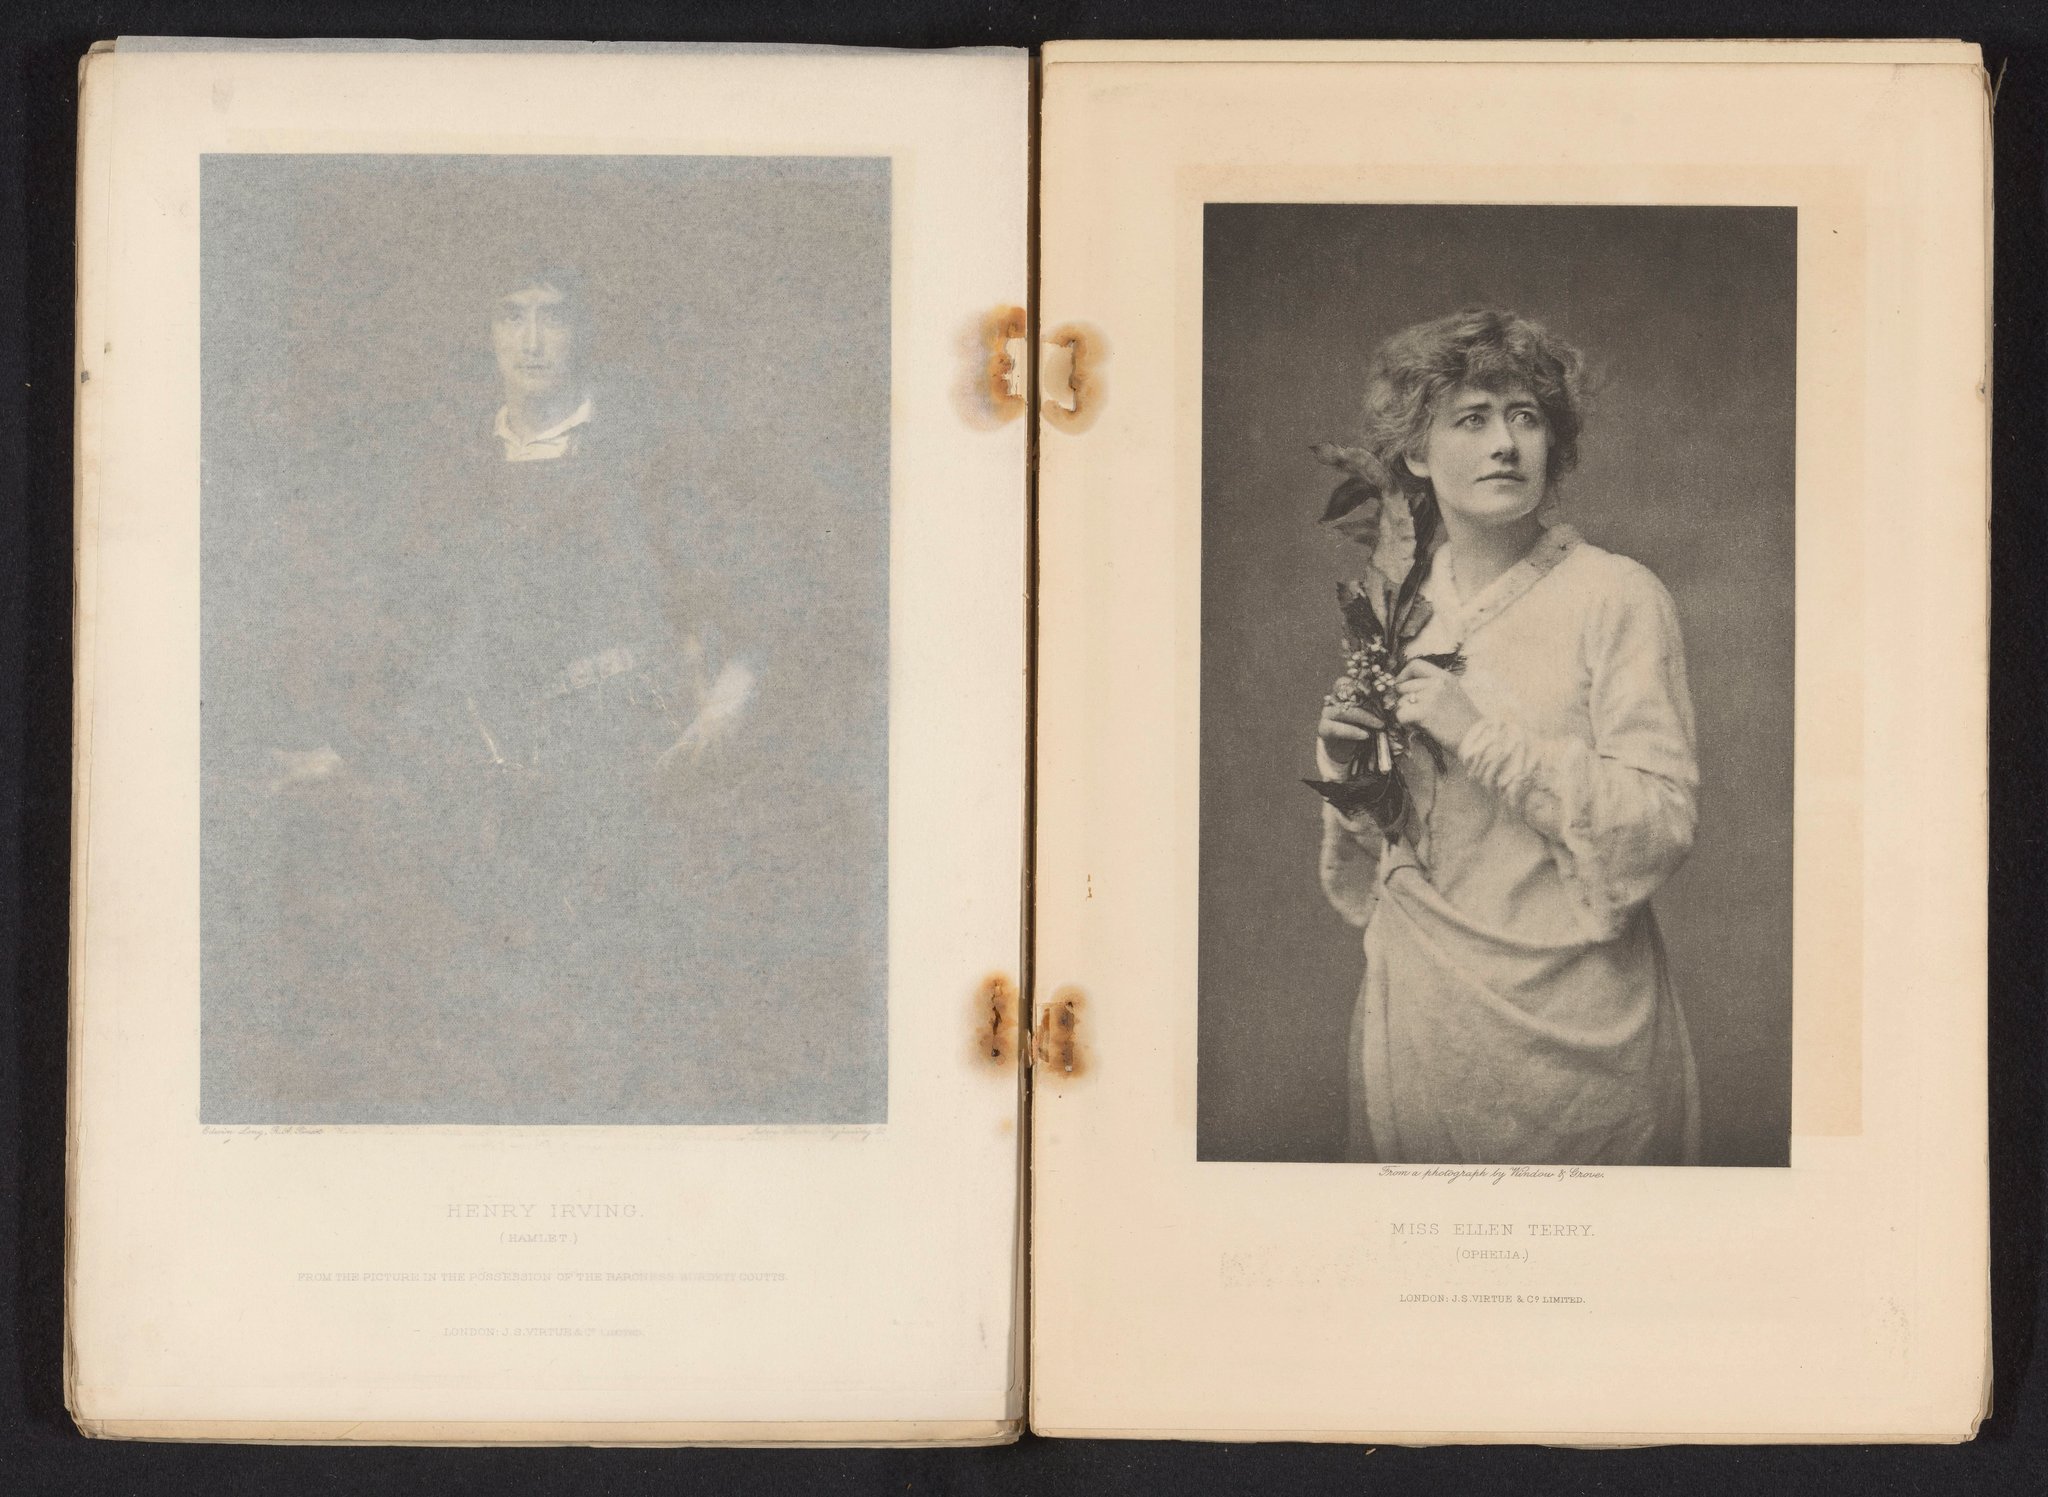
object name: page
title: Miss Ellen Terry (Ophelia)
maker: Anonymous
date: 1880-1890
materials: paper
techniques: photoaquatint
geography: london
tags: portrait of actor, actress